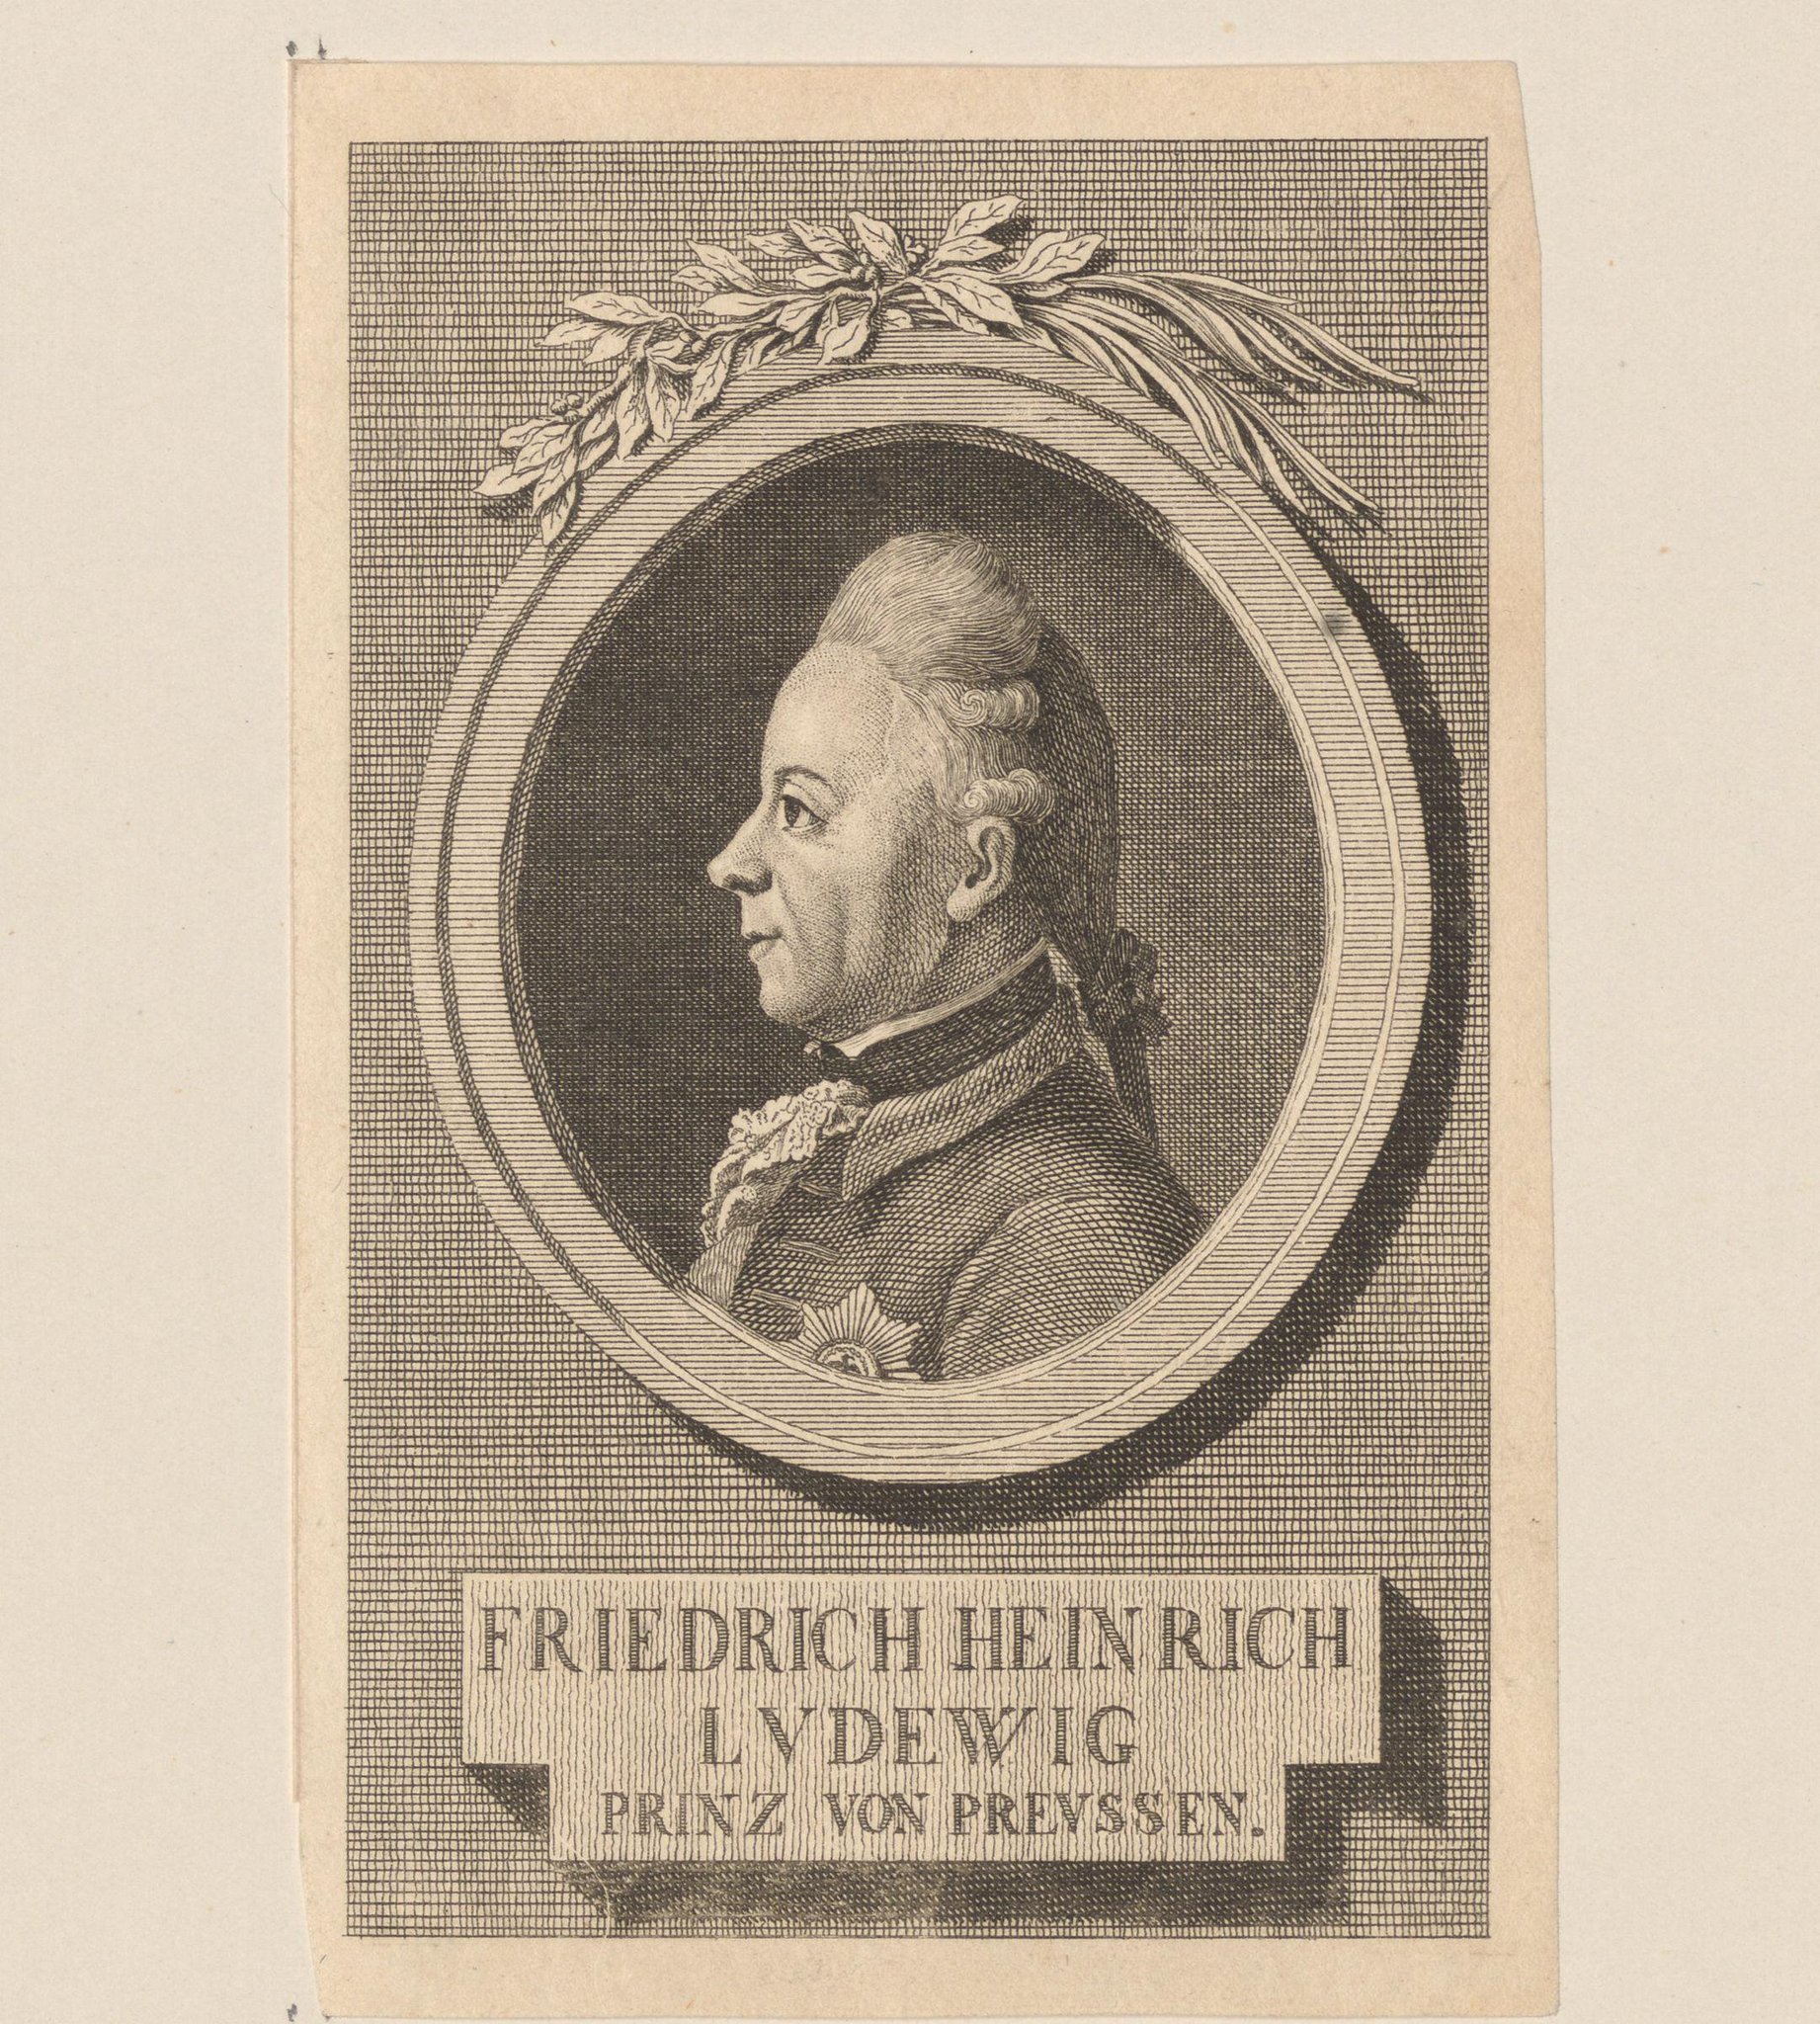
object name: print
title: Portret van Friedrich Heinrich Ludwig van Pruisen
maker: Anonymous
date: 1750-1799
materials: paper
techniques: engraving, etching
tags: berlin, friedrich heinrich ludwig van pruisen, prince, historical persons